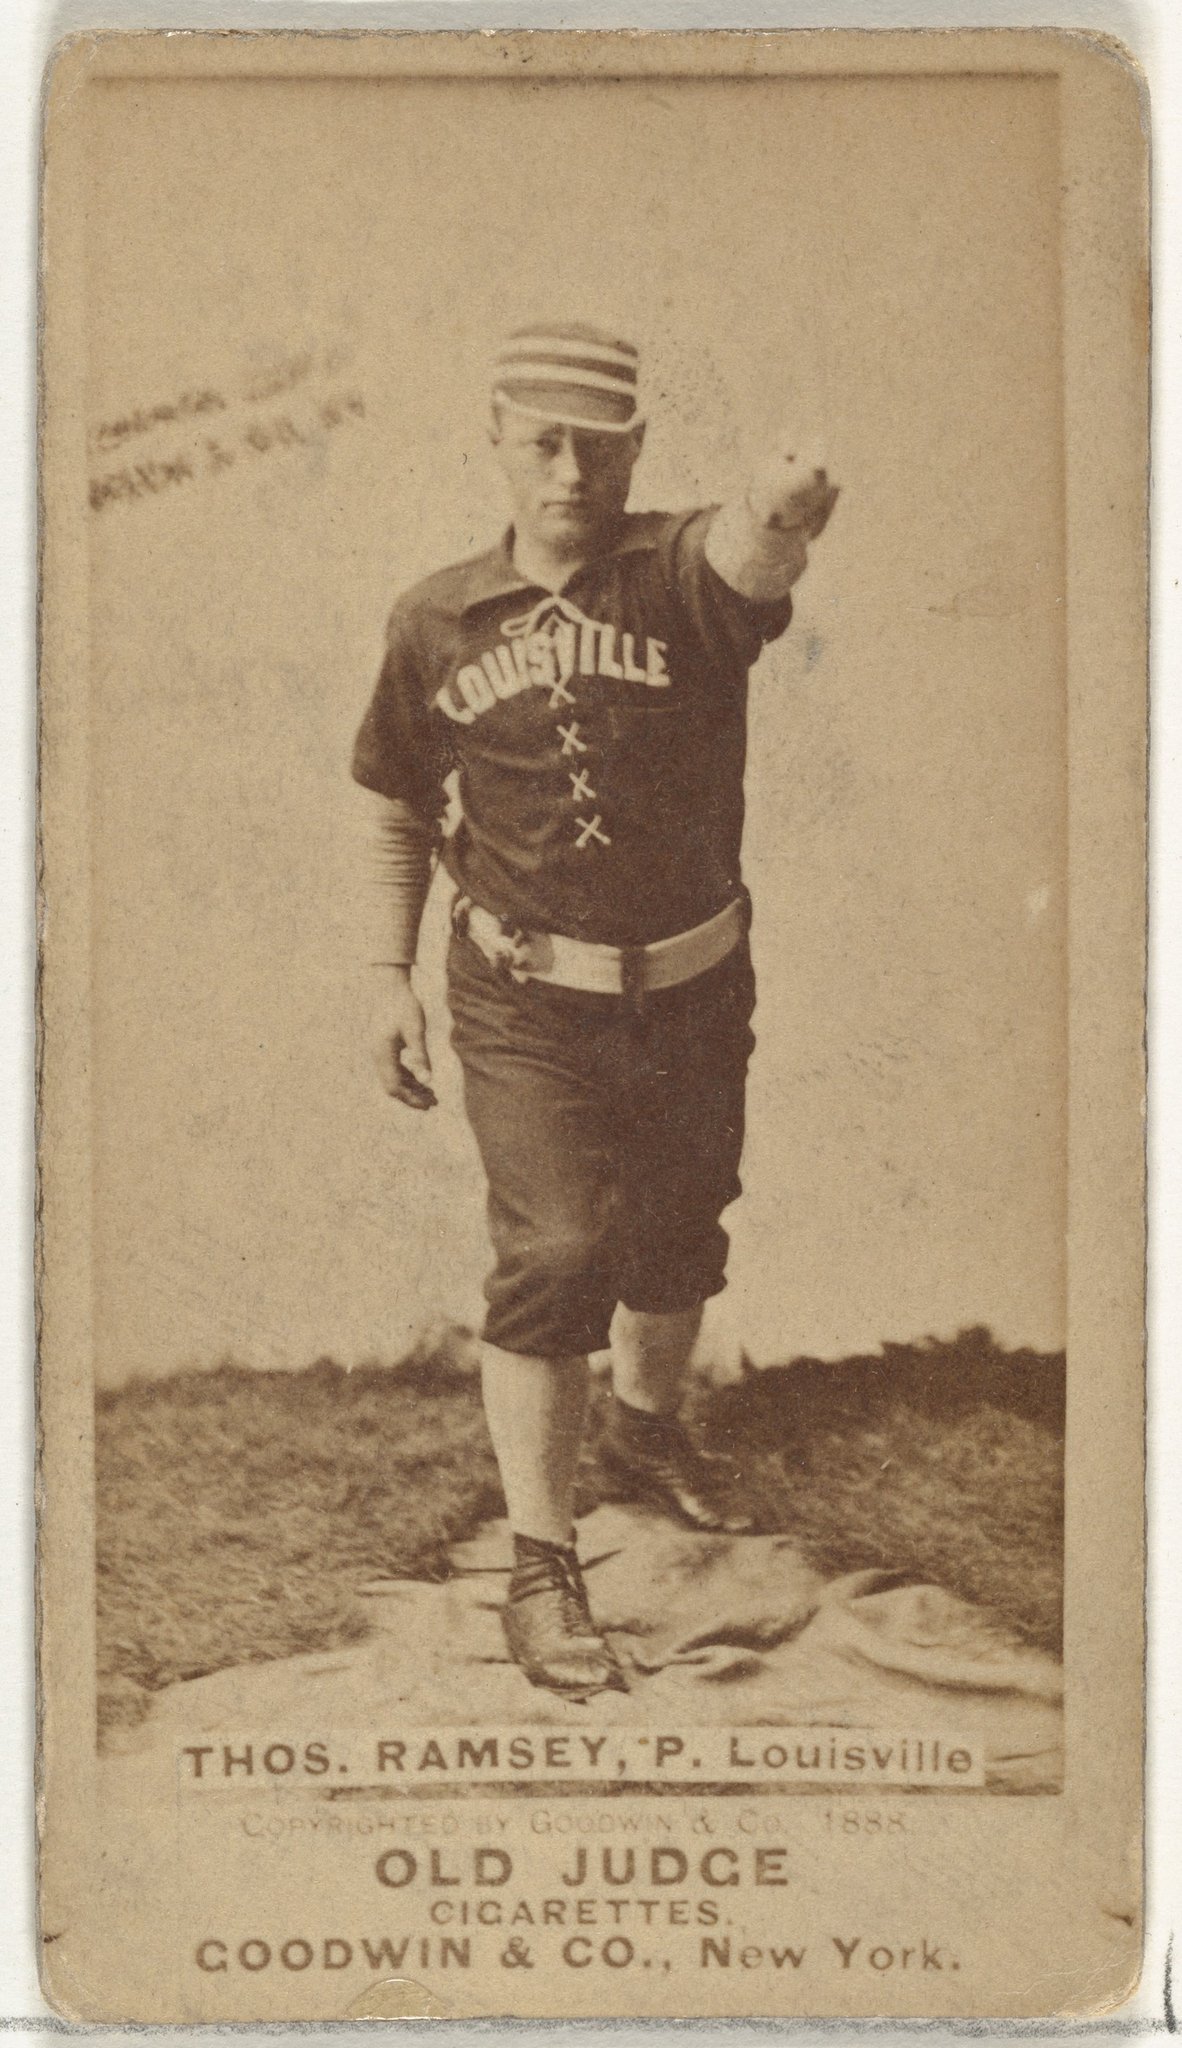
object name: baseball card, photograph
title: Thomas H. "Toad" Ramsey, Pitcher, Louisville Colonels, from the Old Judge series (N172) for Old Judge Cigarettes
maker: goodwin & company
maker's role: publisher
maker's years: 1850-1950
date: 1888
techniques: albumen silver print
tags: men,portraits,baseball,athletes